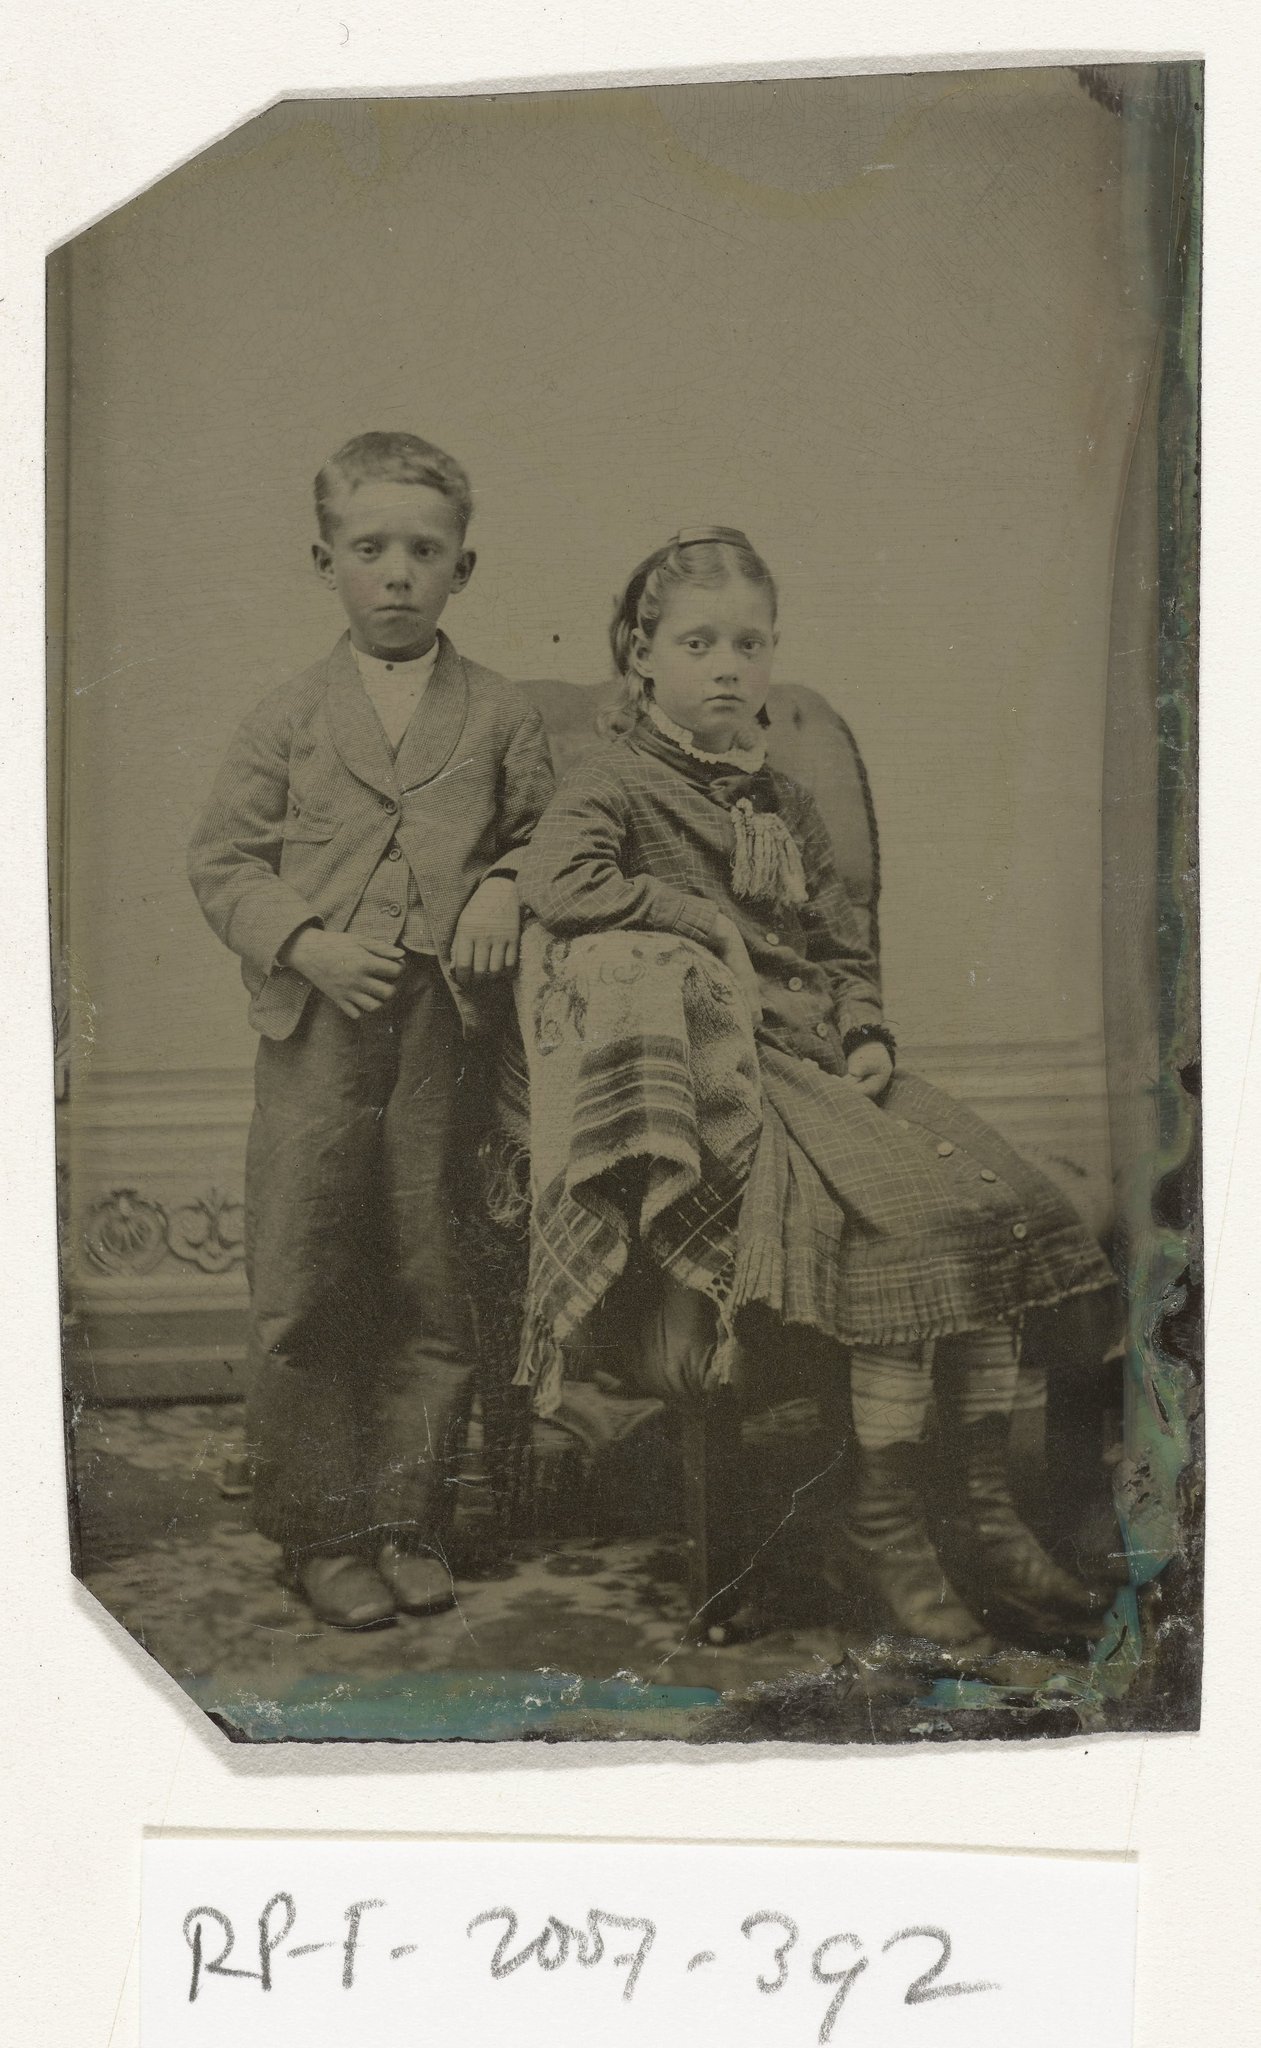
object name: photograph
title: Portret van een meisje en jongen (broer en zus?), zittend en staand in een studiodecor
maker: Anonymous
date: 1880-1910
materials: metal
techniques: ferrotyping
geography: united states